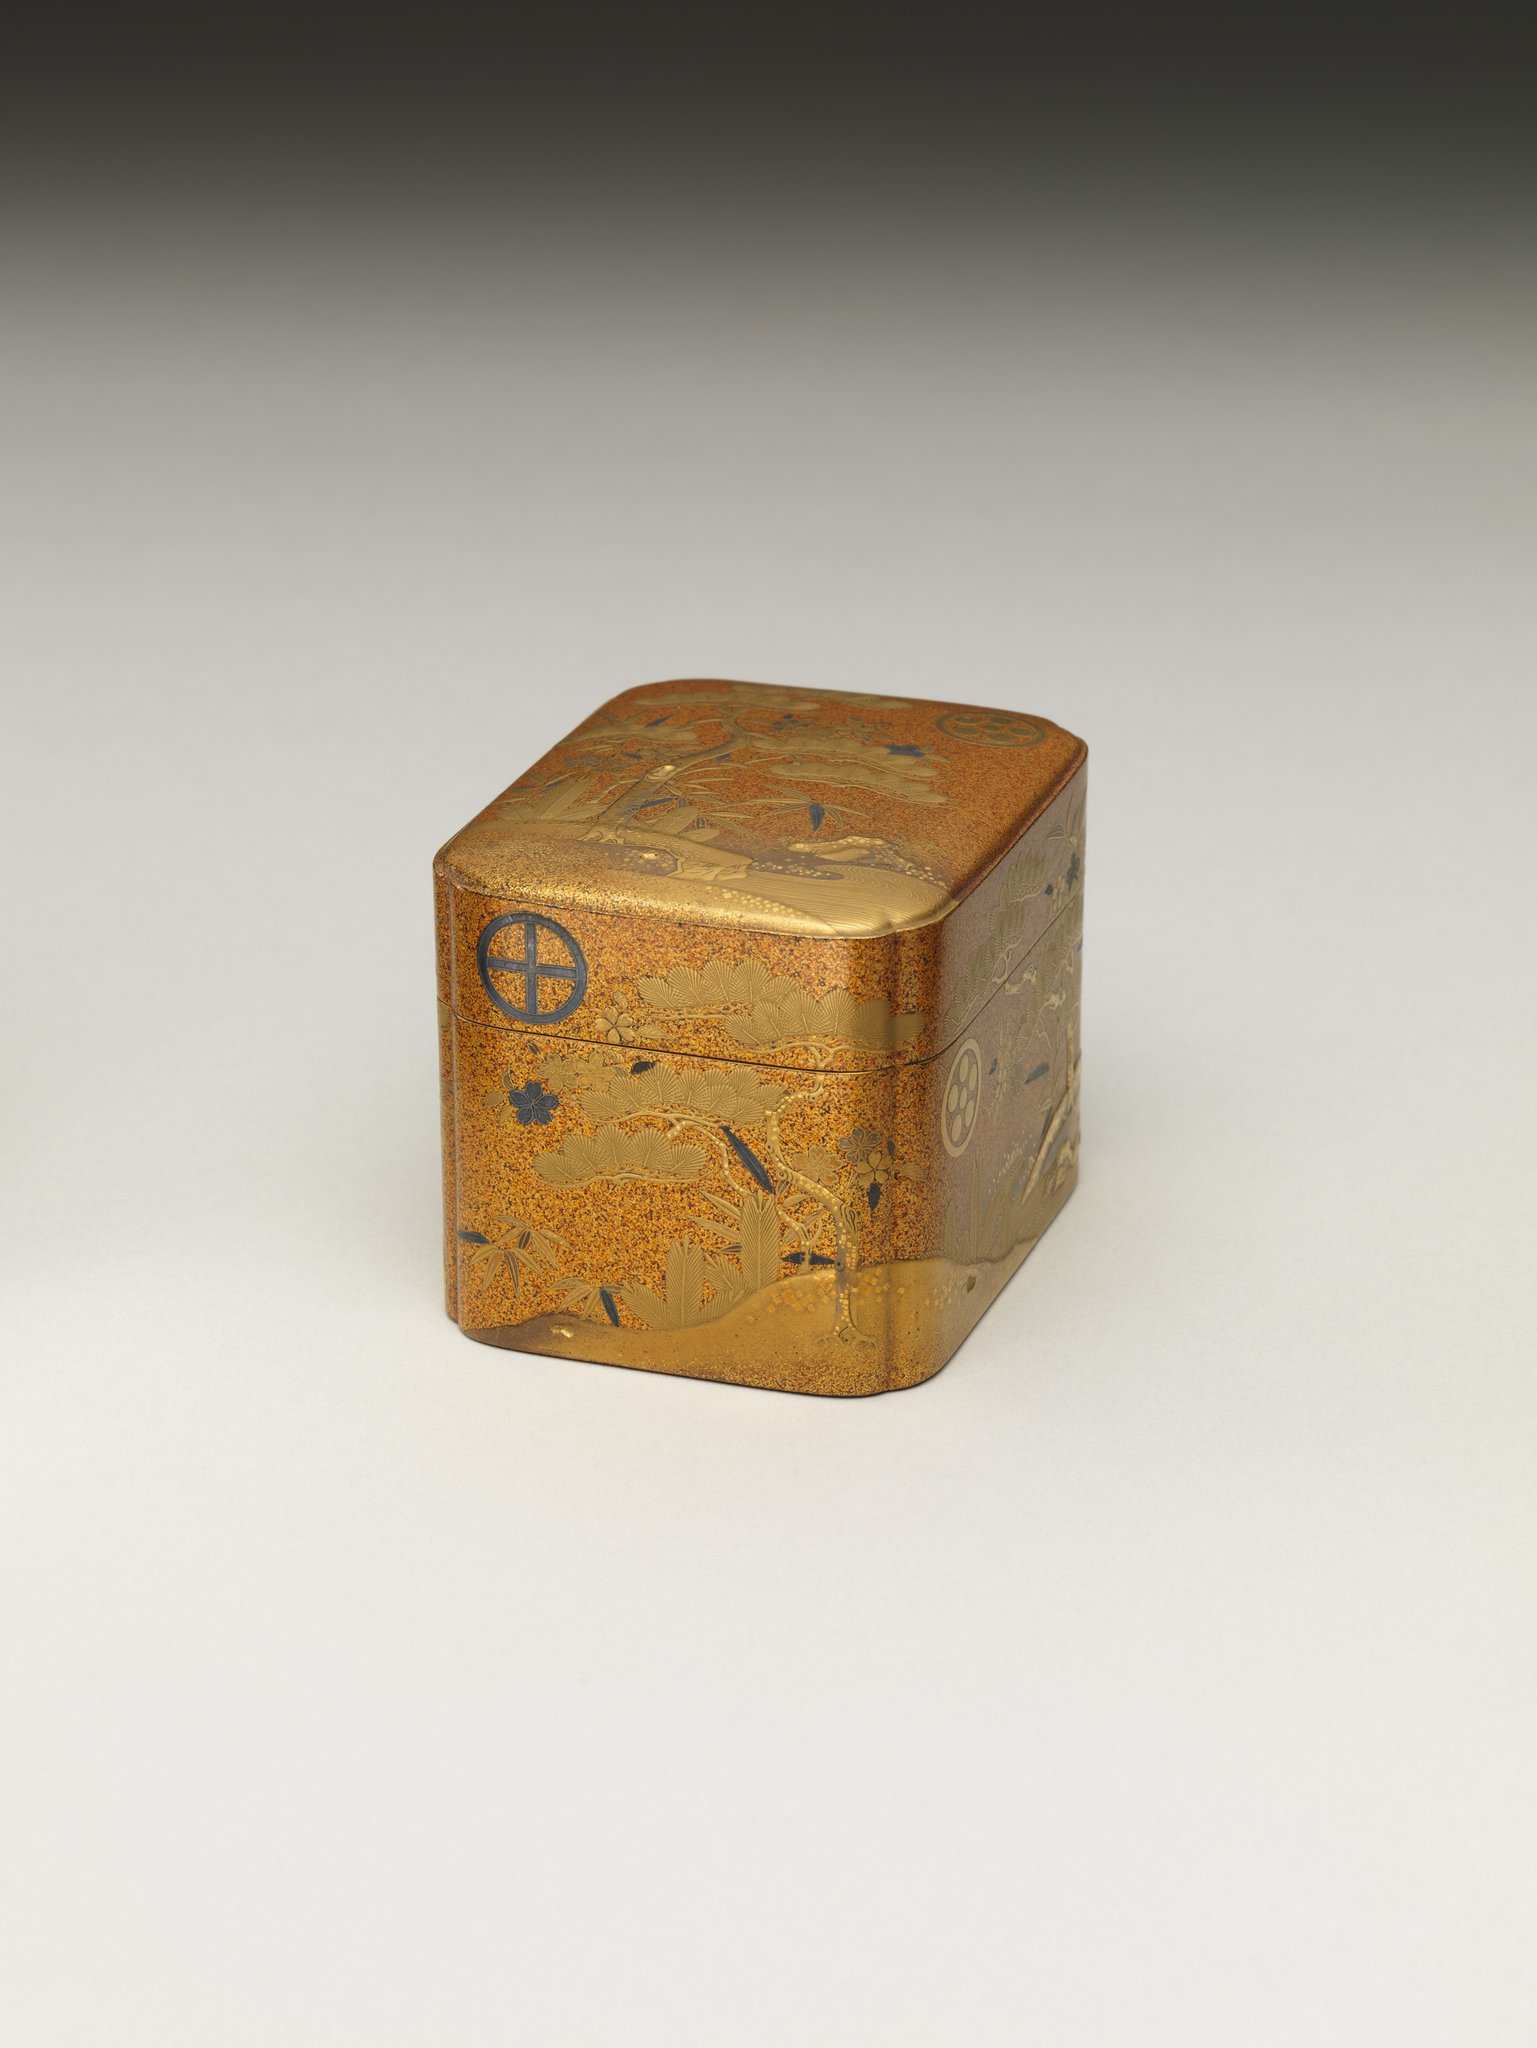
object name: box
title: Box with Design of Pine, Bamboo, and Cherry Blossom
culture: japanese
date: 1801-1900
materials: gold, lacquer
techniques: maki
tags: trees